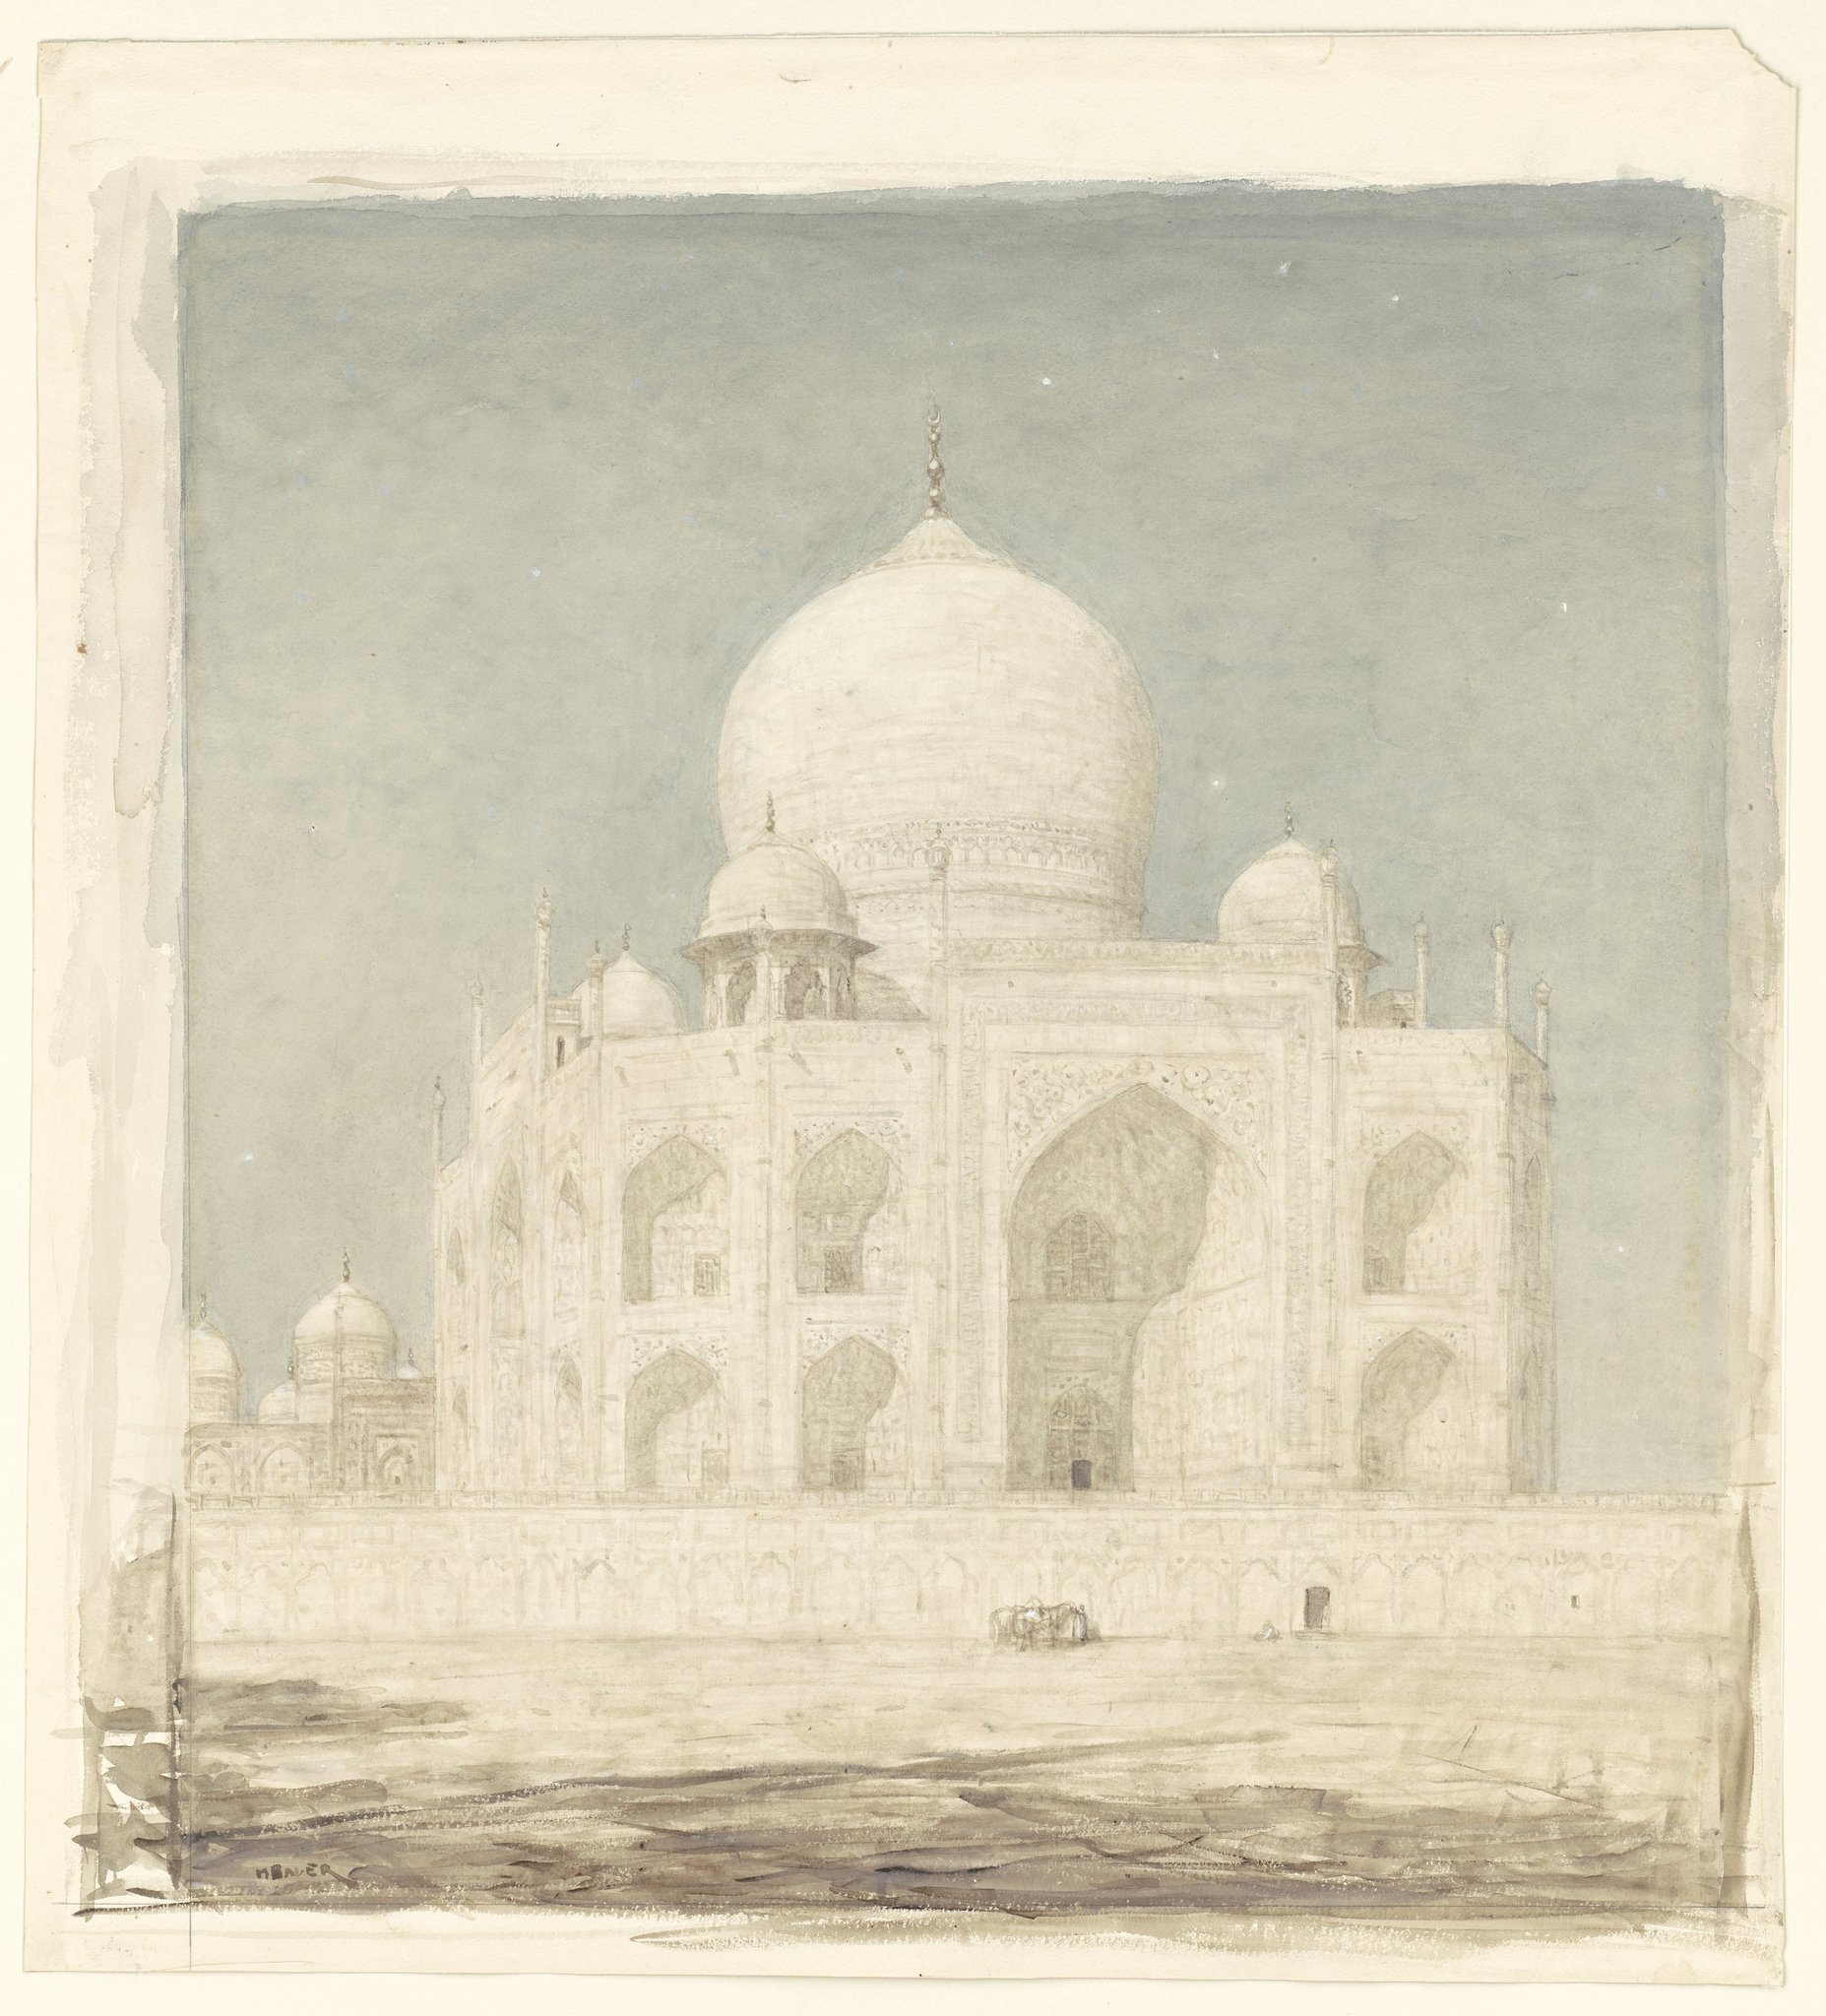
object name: watercolor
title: De Taj Mahal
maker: marius bauer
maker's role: draughtsman, print maker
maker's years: 1867-1932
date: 1898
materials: paper, pencil, watercolor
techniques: brush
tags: grave-building, monumental tomb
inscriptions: signature: ‘M. Bauer’